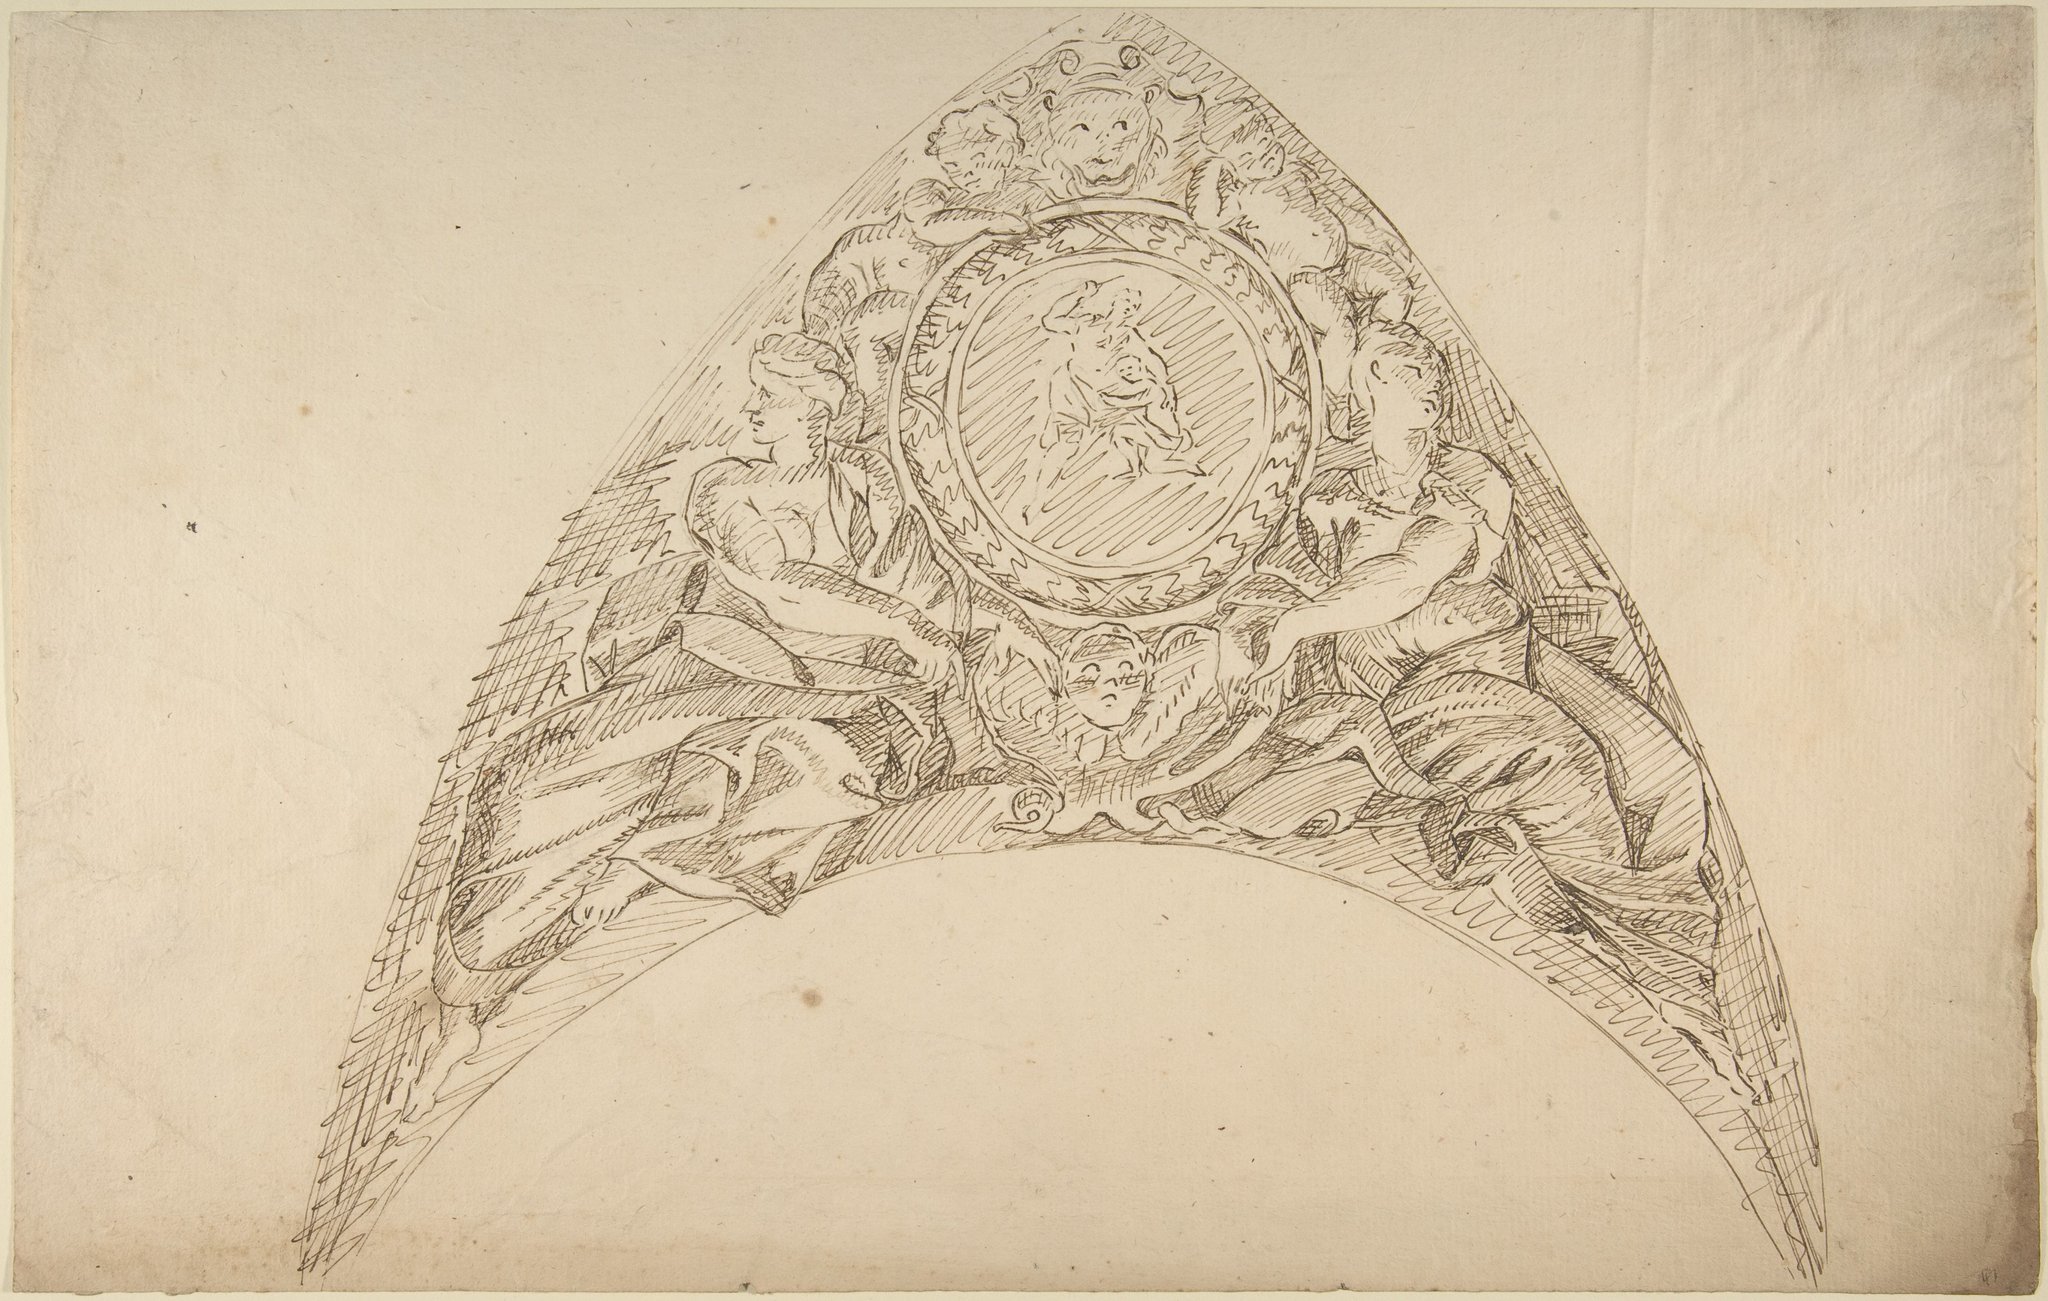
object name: drawing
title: Design for a Pedentive Decoration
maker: anonymous, italian, piedmontese, 18th century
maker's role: artist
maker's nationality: italian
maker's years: 1700-1800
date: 1701-1800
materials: ink, drawing material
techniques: pen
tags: architecture,women